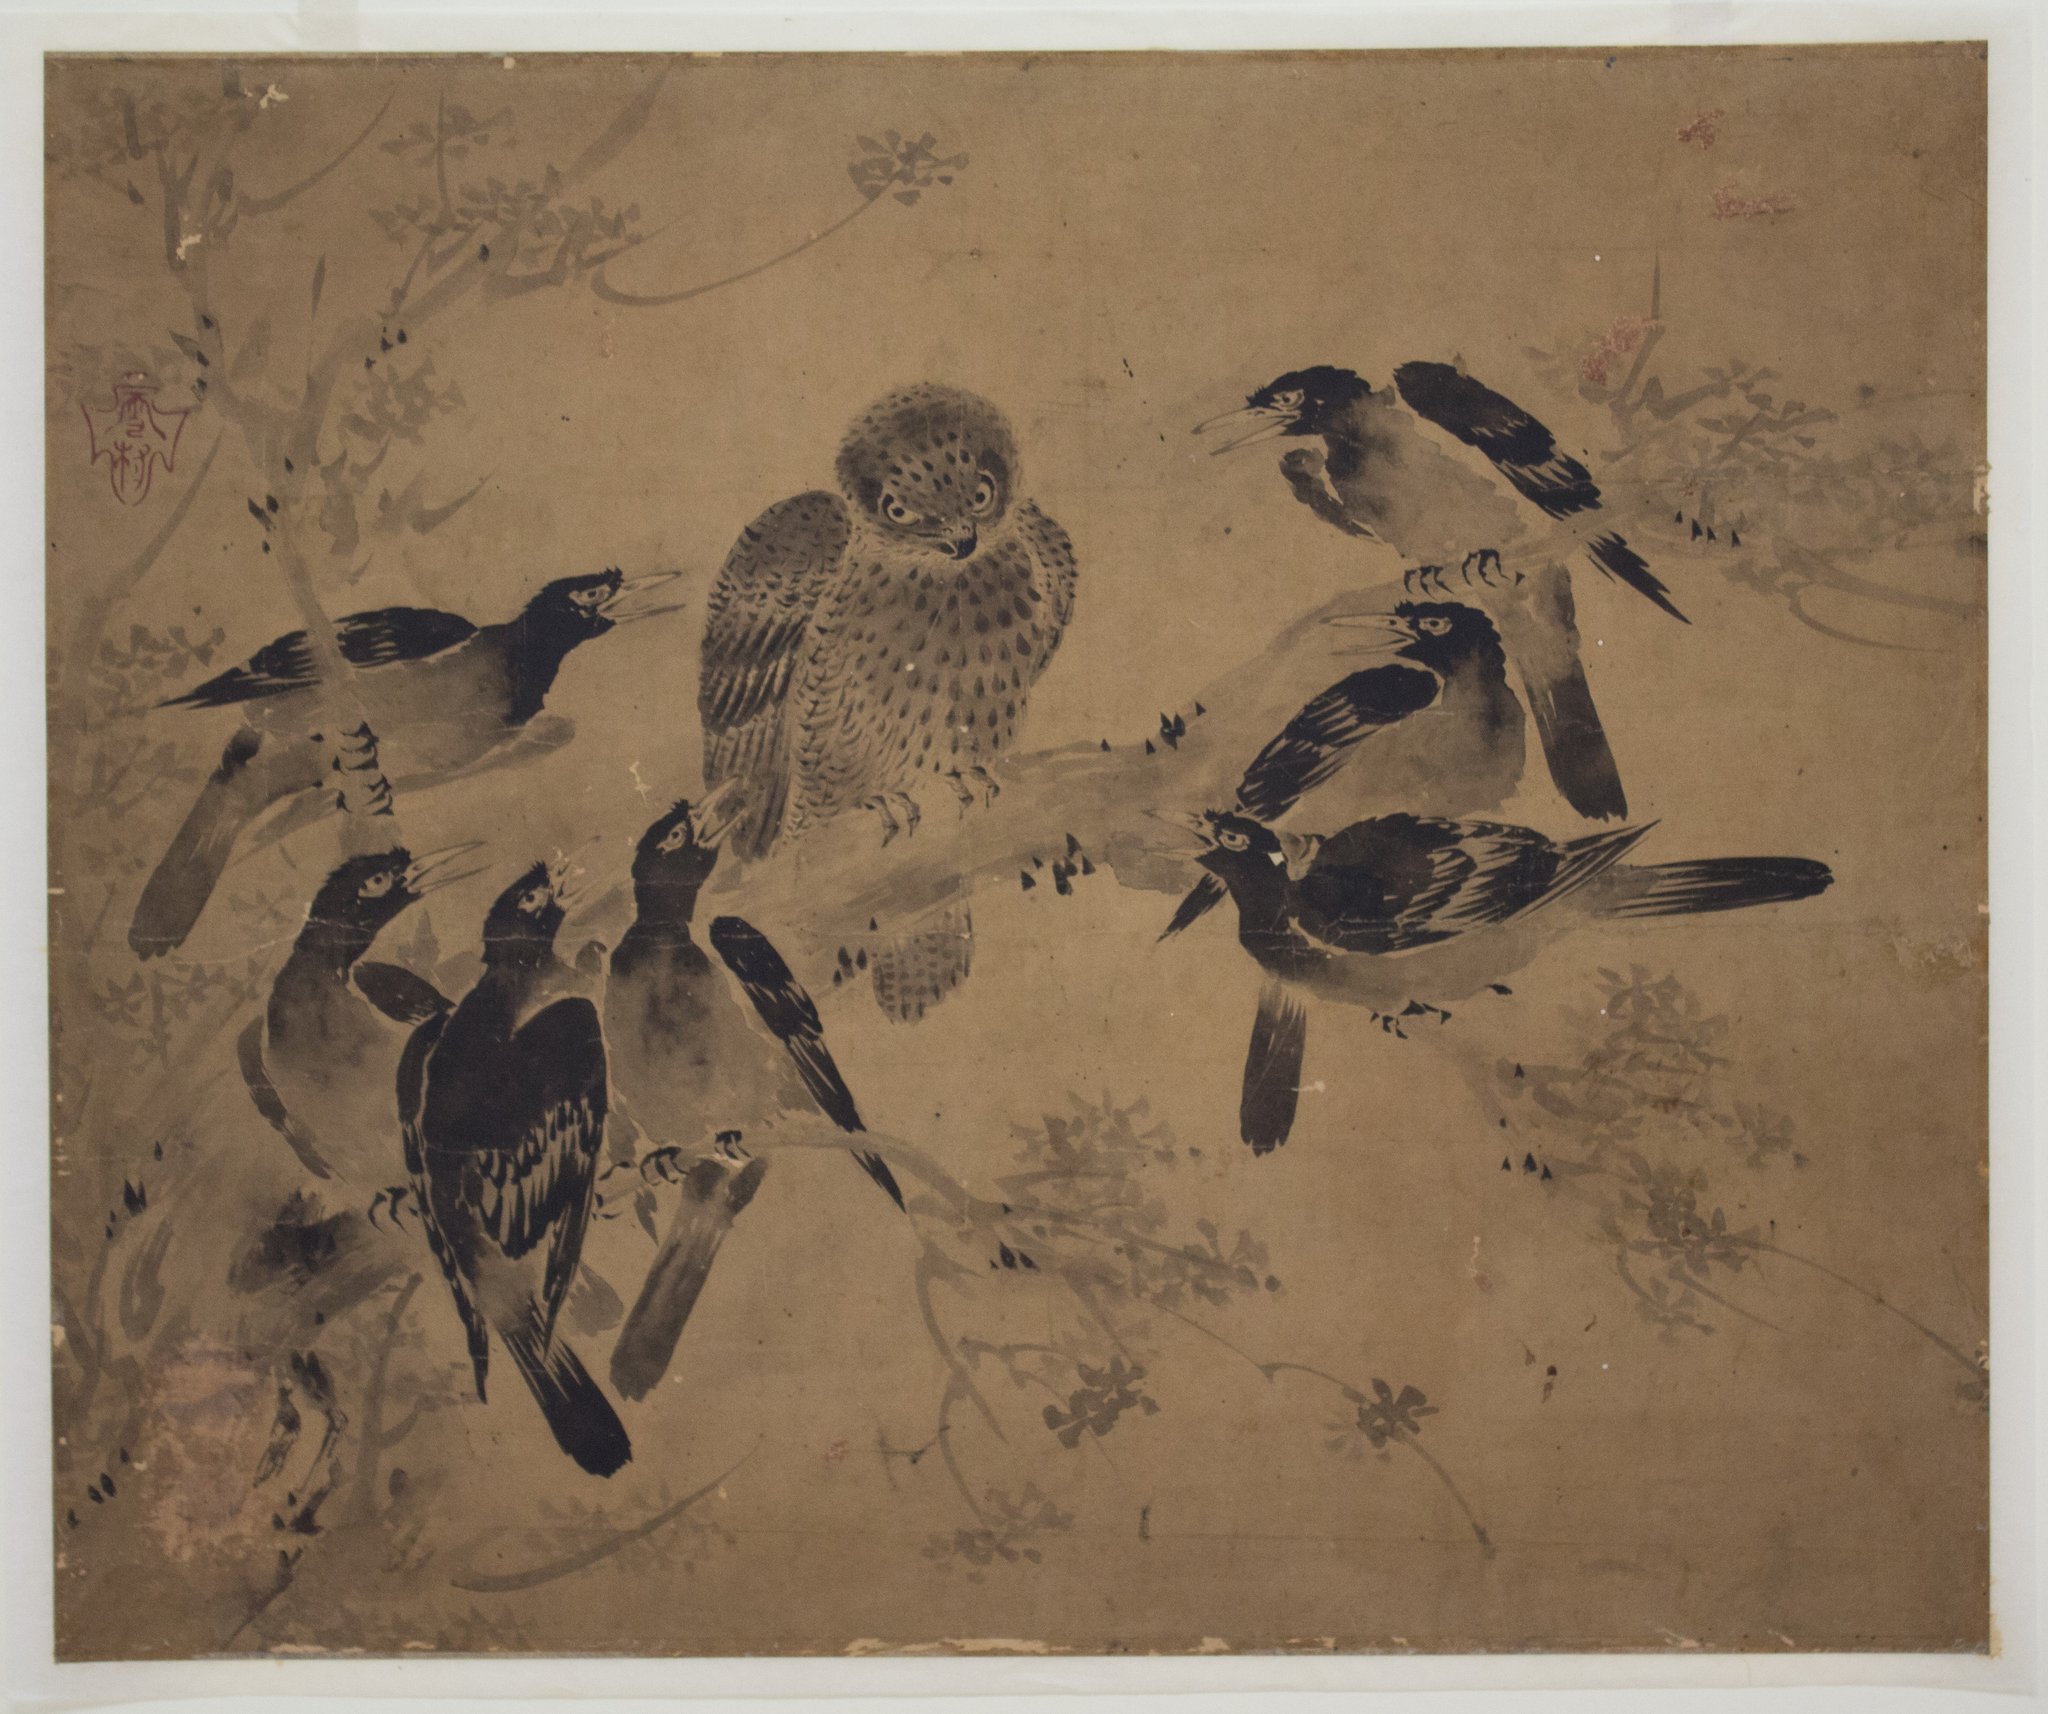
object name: painting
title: Mynah Birds Attacking an Owl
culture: japanese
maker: sesson shūkei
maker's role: artist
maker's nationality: japanese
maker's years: 1504-1589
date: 1801-1900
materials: ink, paper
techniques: painting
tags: birds,owls